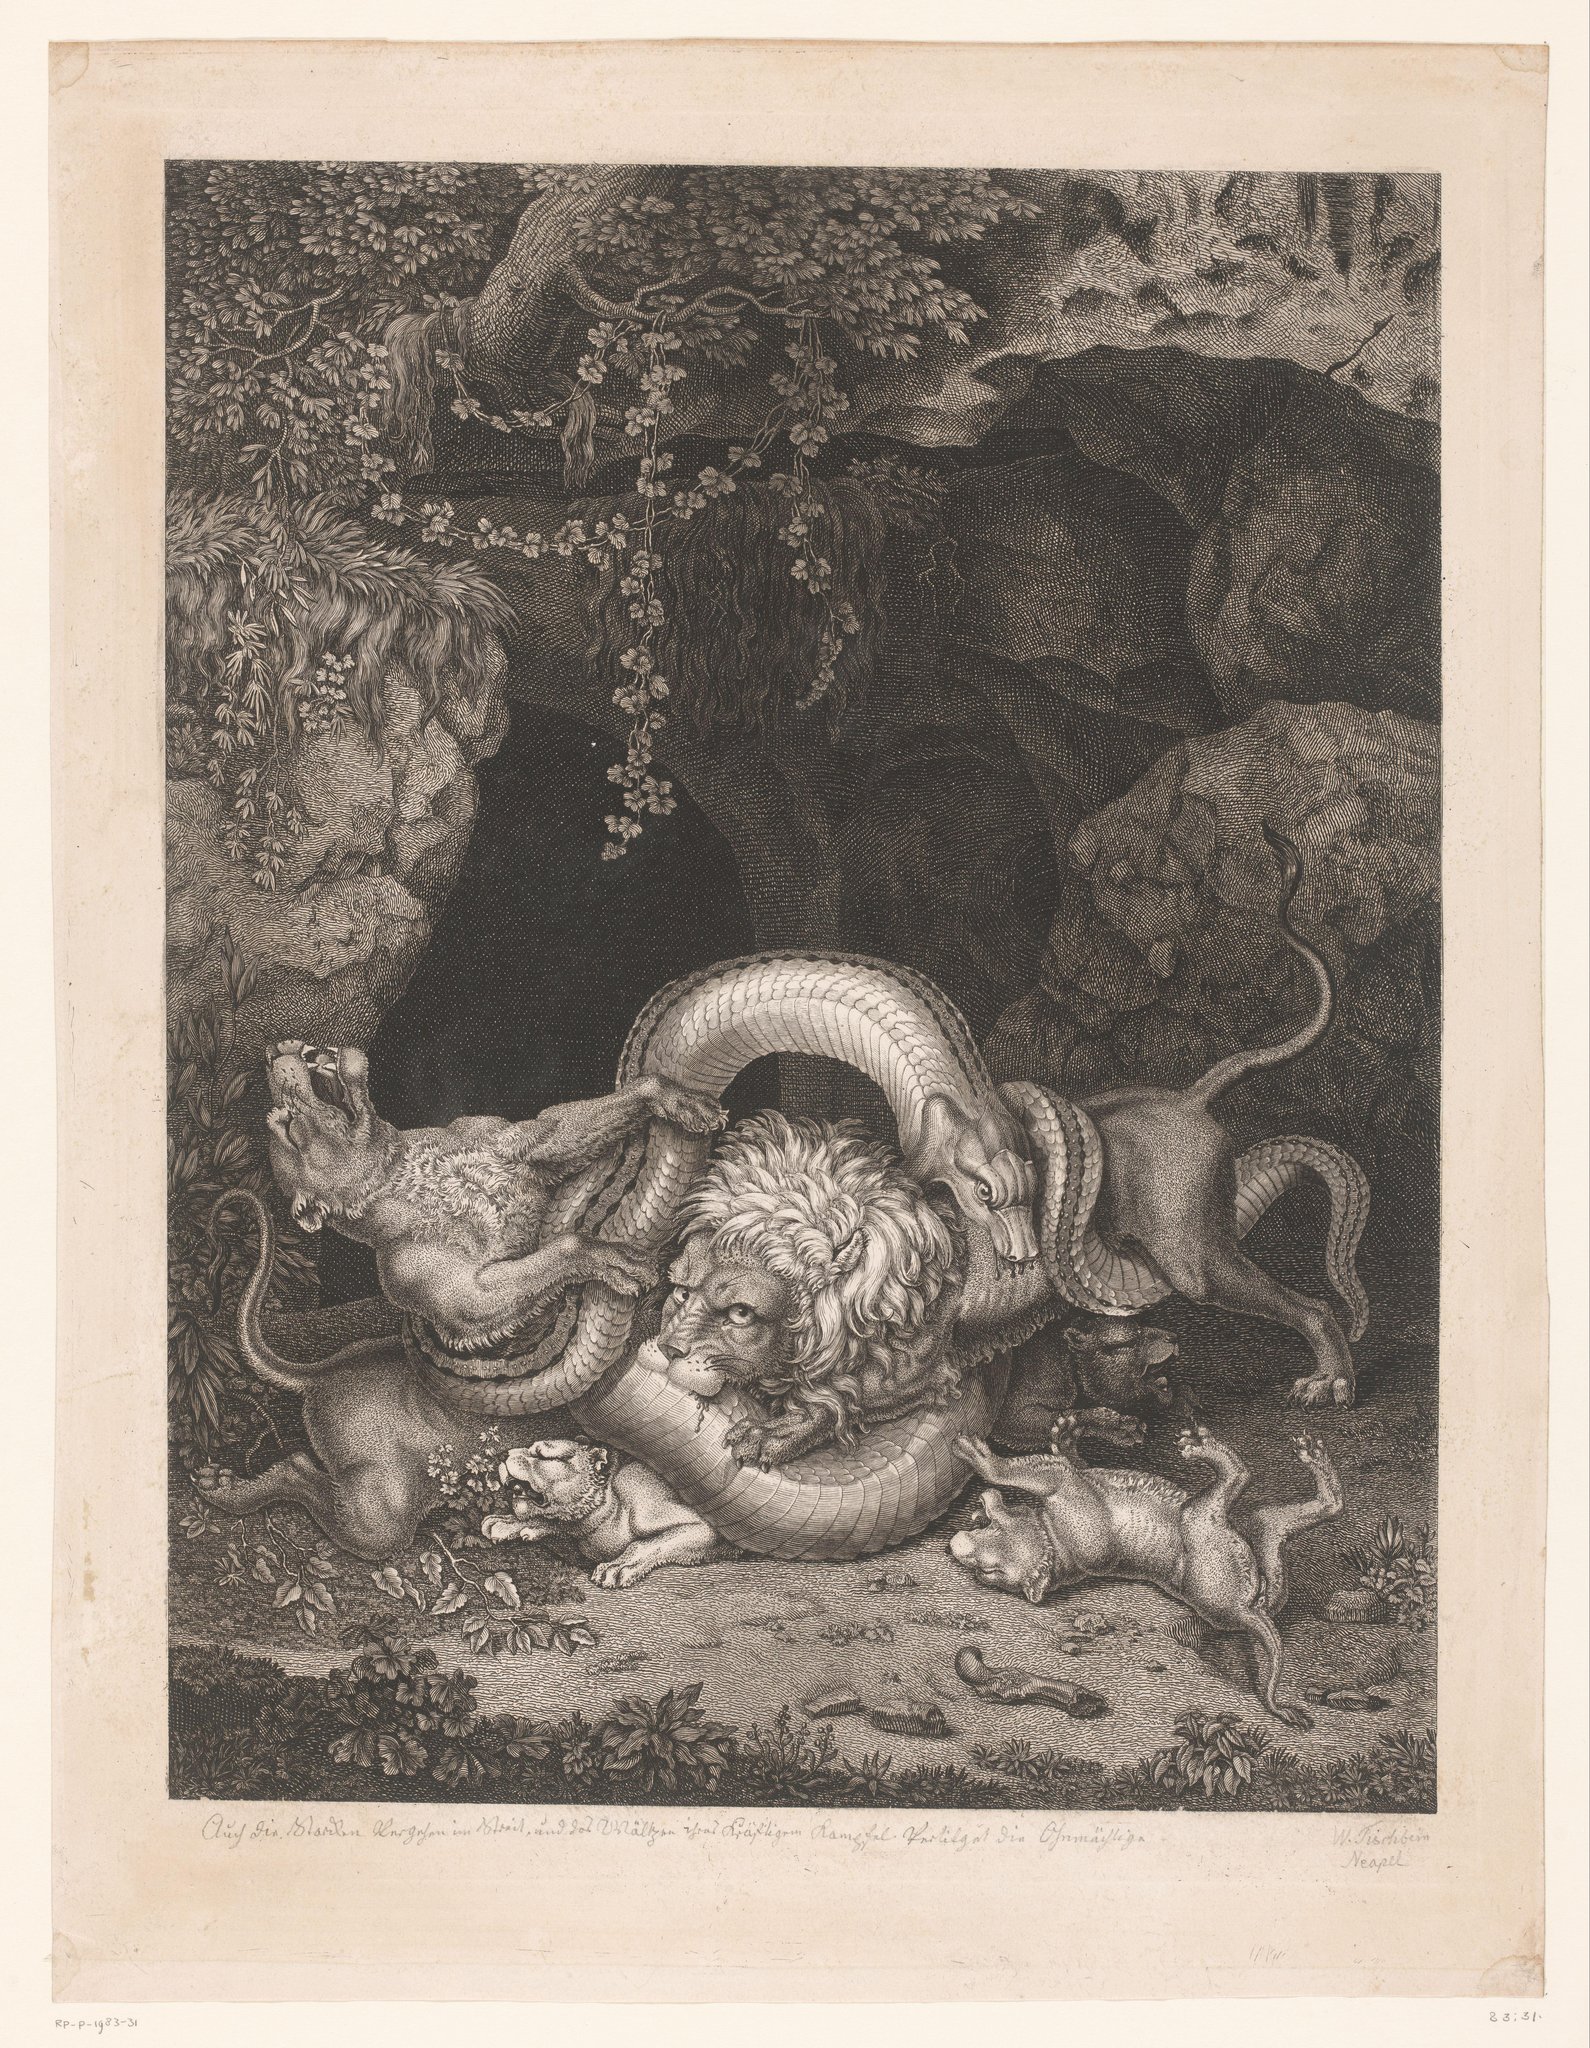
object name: print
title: Leeuw en leeuwin beschermen welpen tegen een slang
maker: wilhelm tischbein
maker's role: painter, print maker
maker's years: 1751-1829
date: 1796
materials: paper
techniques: etching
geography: naples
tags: snakes, beasts of prey, predatory animals: lion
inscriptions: collector's mark: Lugt 2760, collector's mark: Lugt 2228